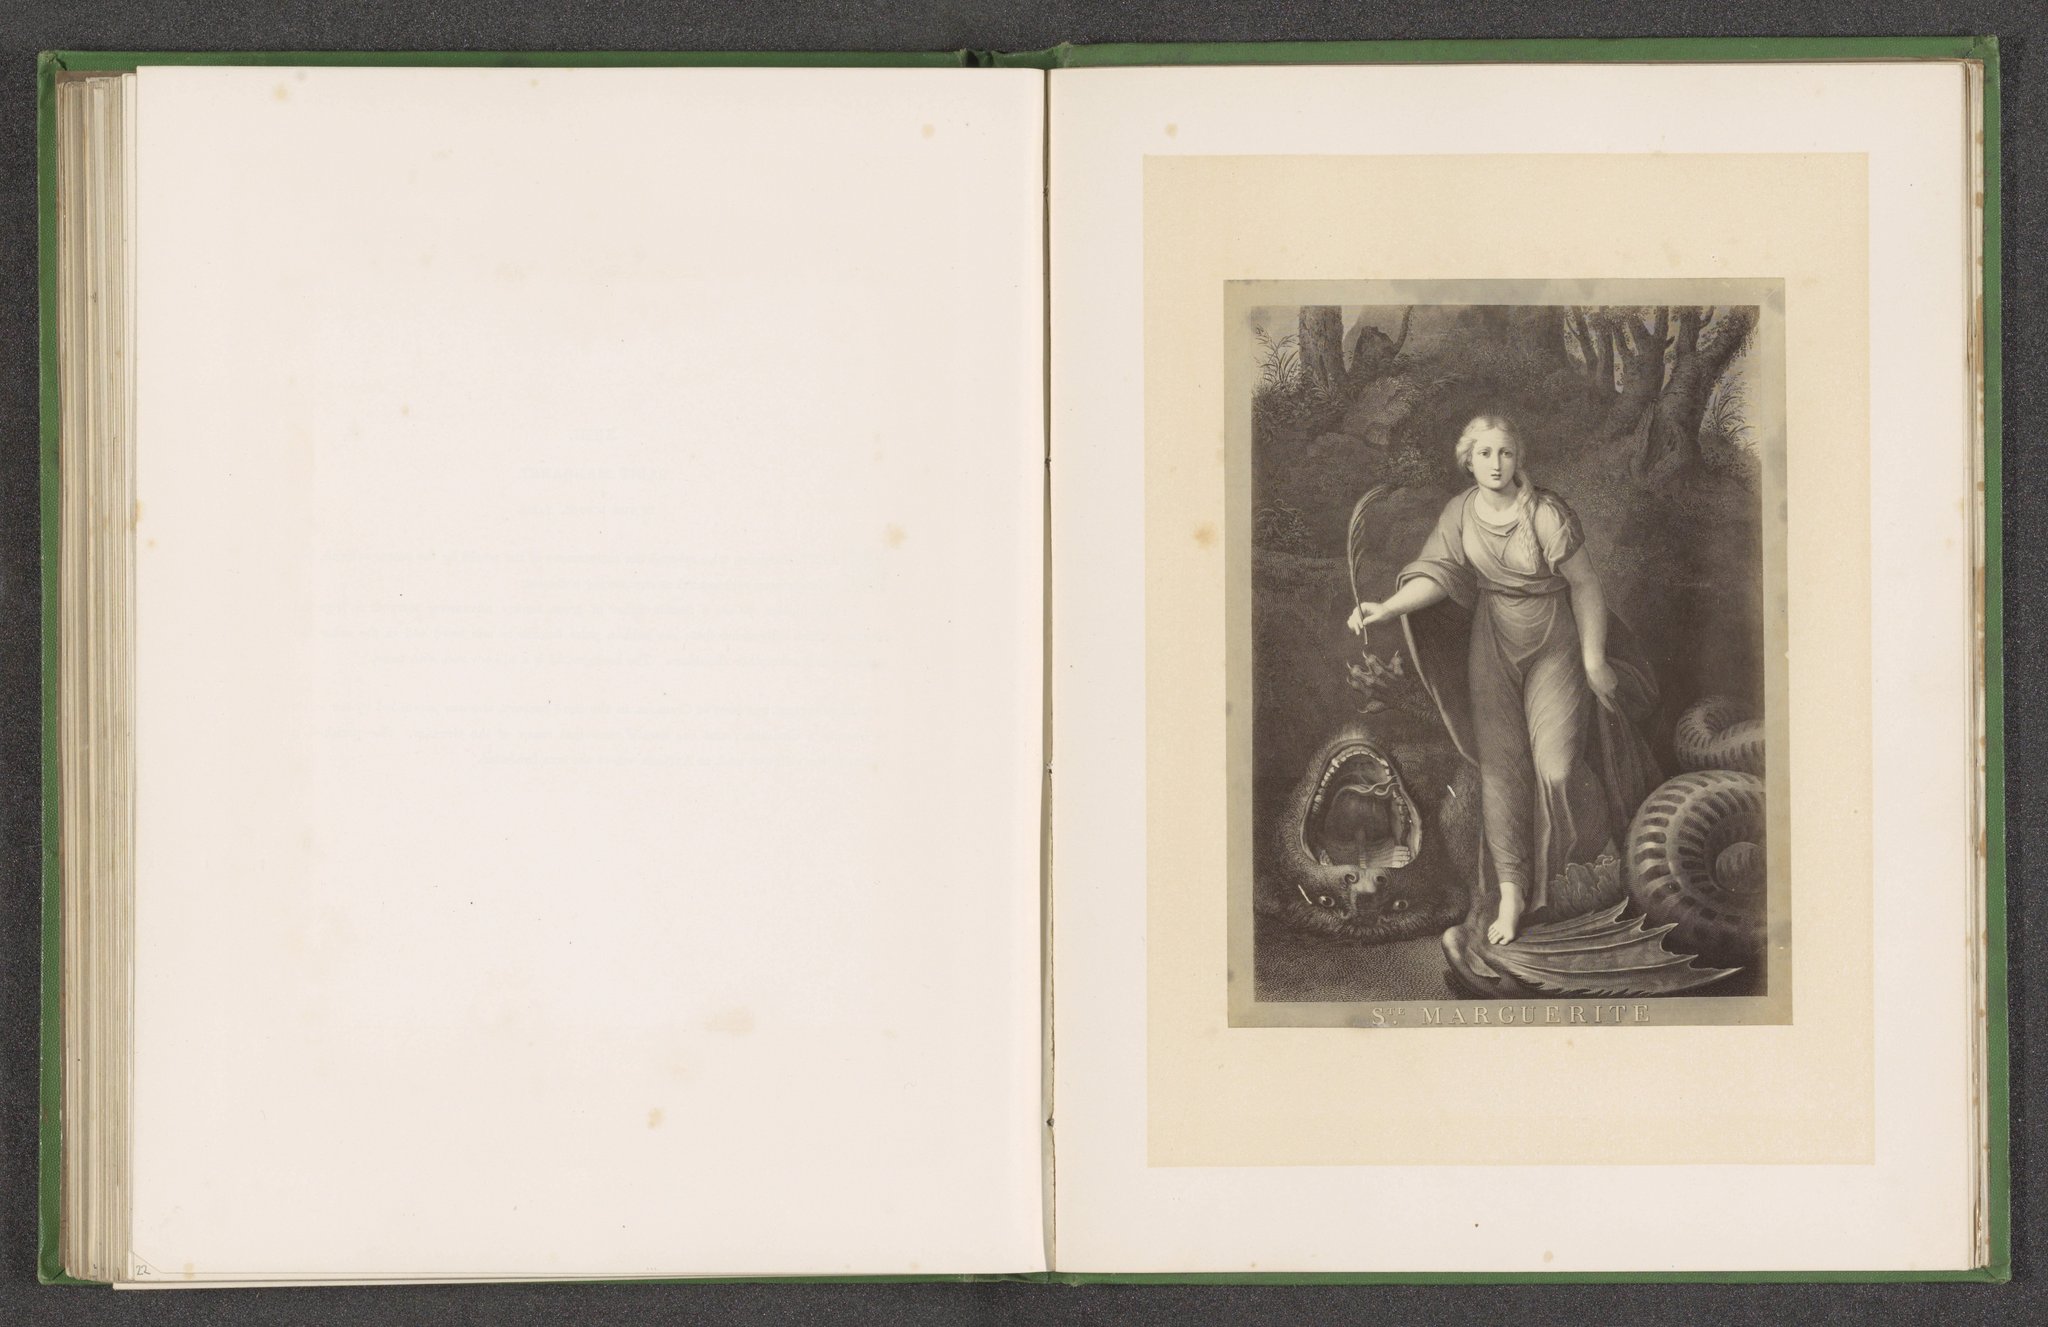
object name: photograph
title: Fotoreproductie van een prent door B. Desnoyers van een schilderij van Margaretha van Antiochië door Rafaël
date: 1859-1869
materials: photographic support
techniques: albumen print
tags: miraculous activities and events ~ st. margaret